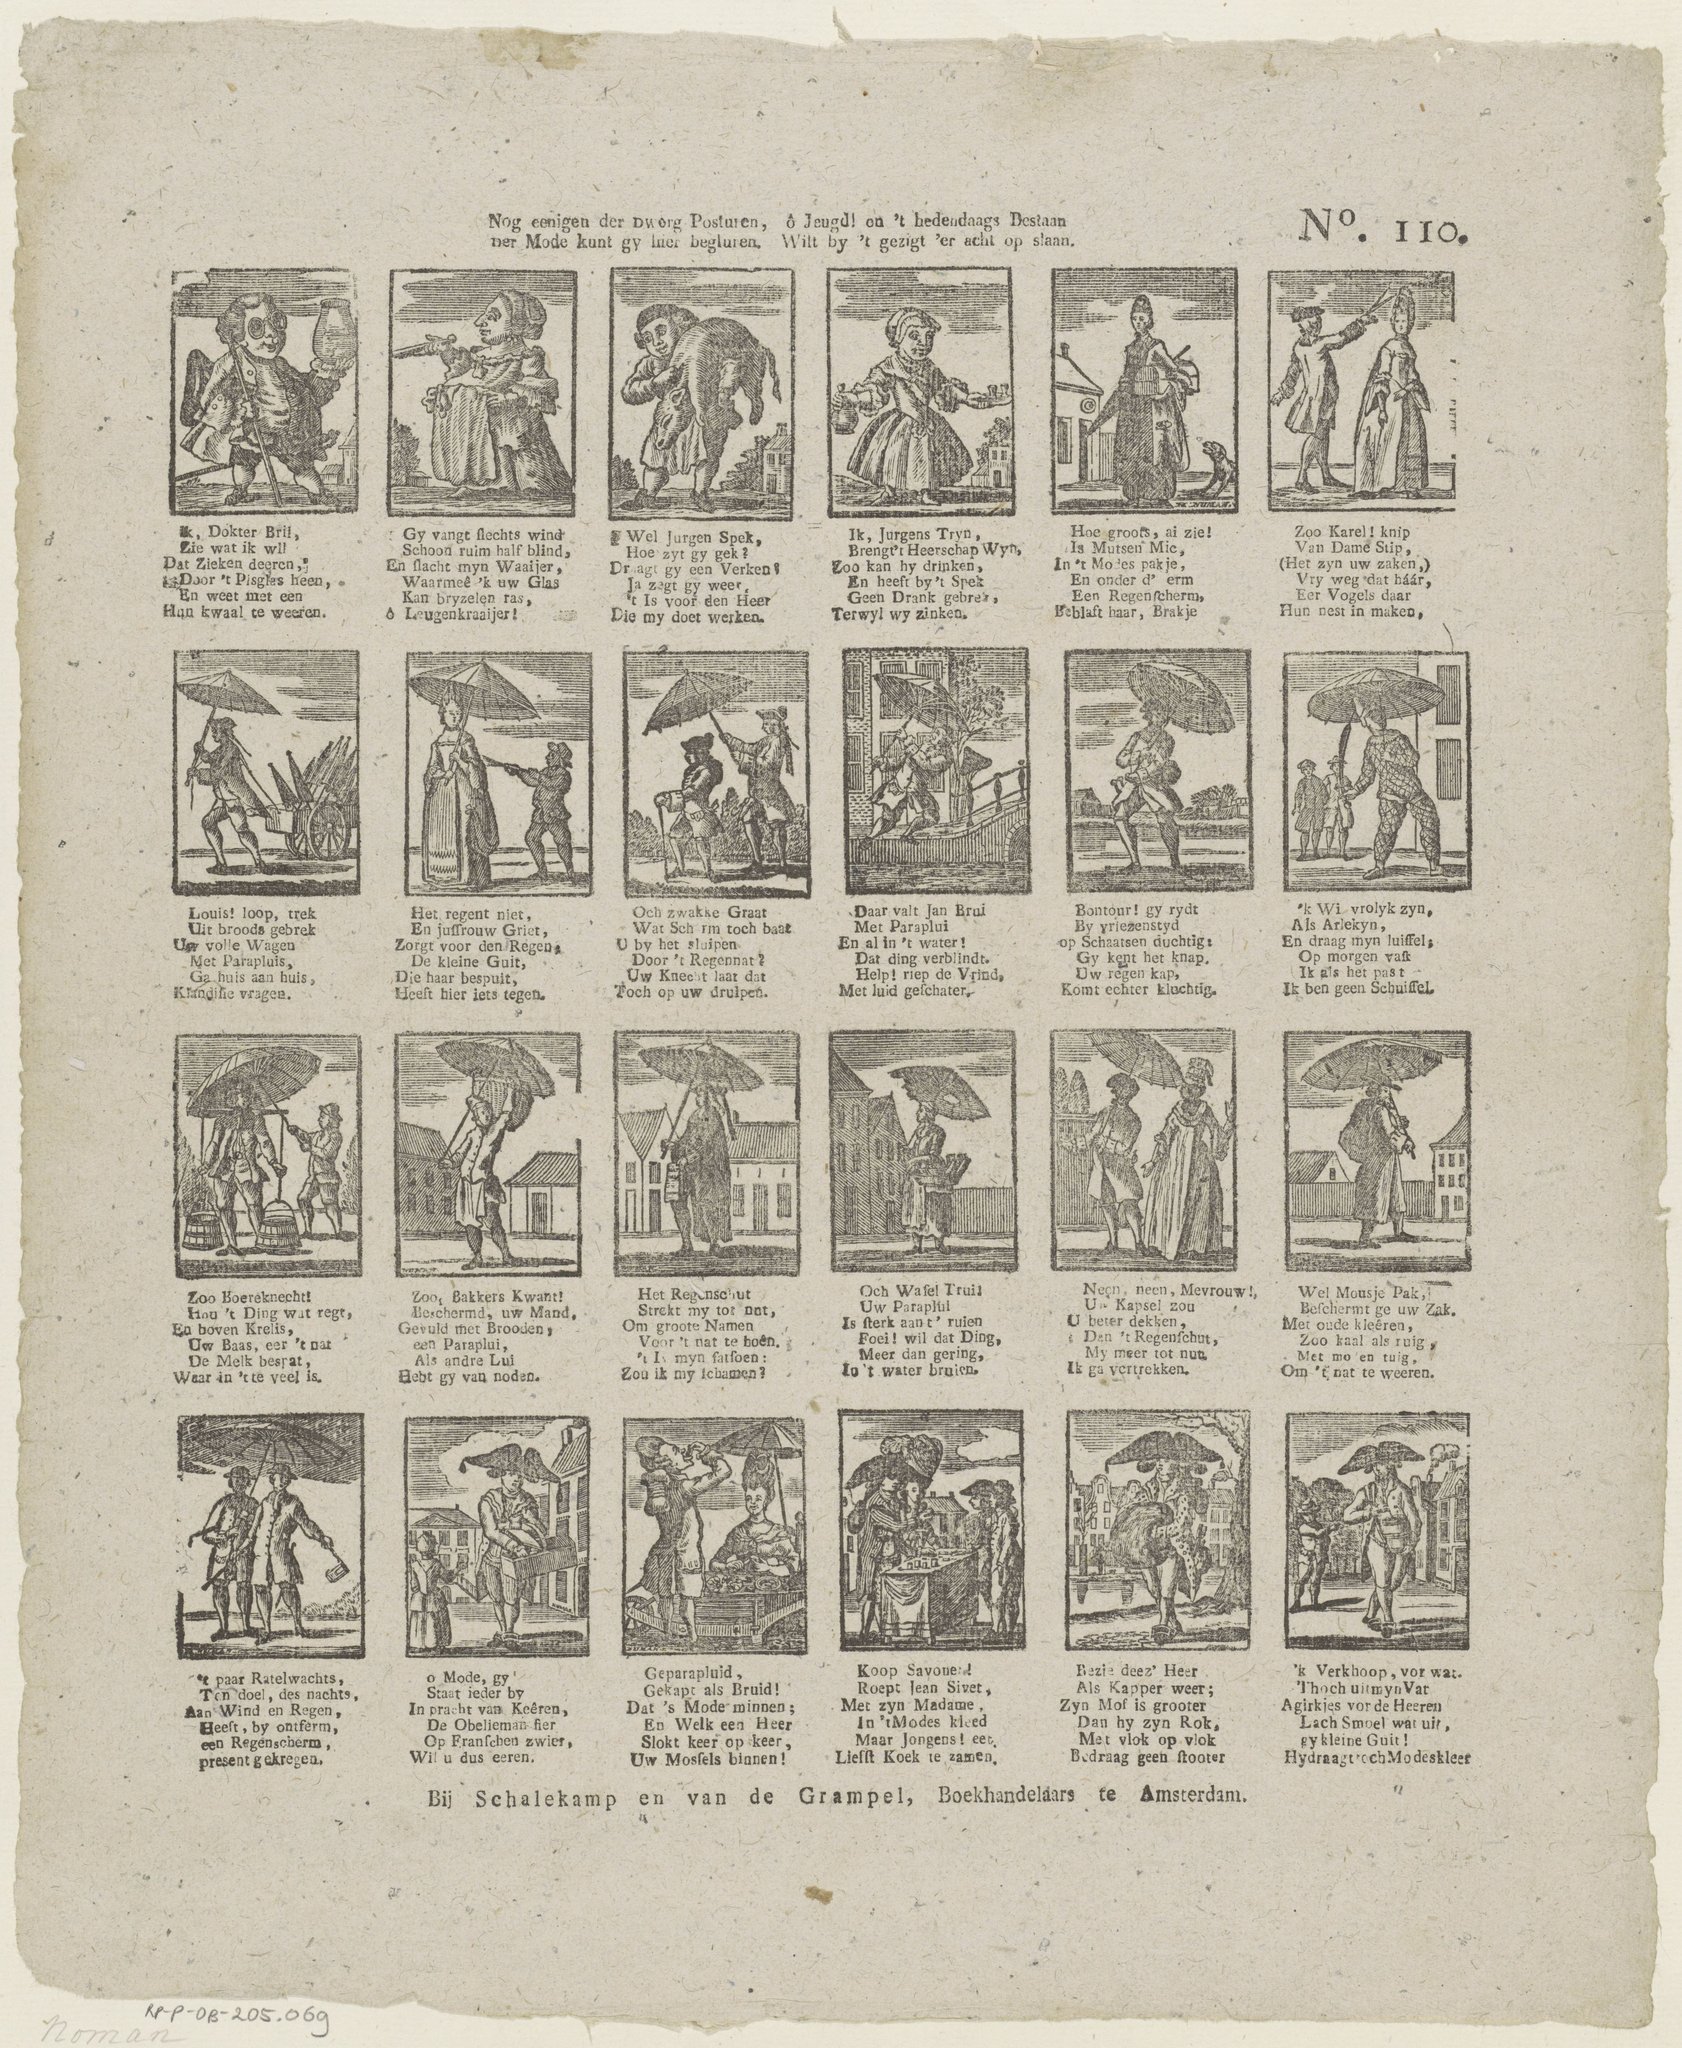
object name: popular print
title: Nog eenigen der dwerg-posturen, ô jeugd! en 't hedendaags bestaan / Der mode kunt gy hier begluren. Wilt by 't gezigt 'er acht op slaan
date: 1806-1830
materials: paper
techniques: letterpress printing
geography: netherlands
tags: fashion, clothing, caricatures (human types), fashion, comedy, parasol, sunshade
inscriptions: collector's mark: Lugt 2760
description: Spotprent op de mode met 24 voorstellingen van een mannen, vrouwen en karikaturele figuren met parasollen. Onder elke afbeelding een zesregelig vers. Genummerd rechtsboven: No. 110.